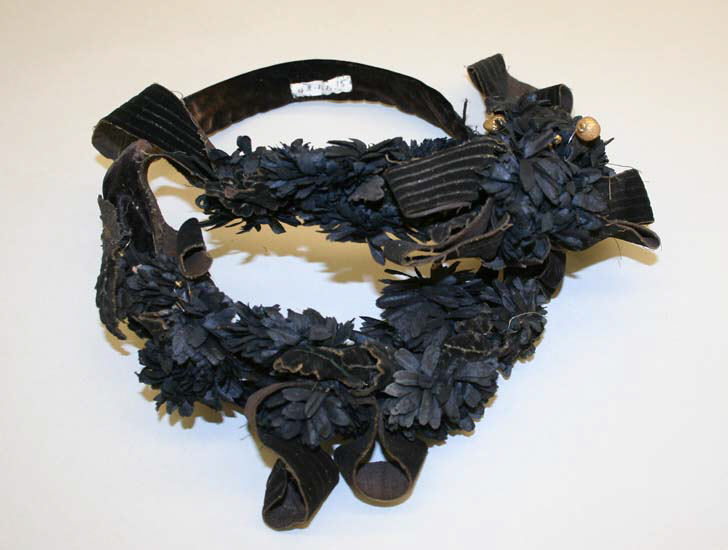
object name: coronet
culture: american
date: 1860-1869